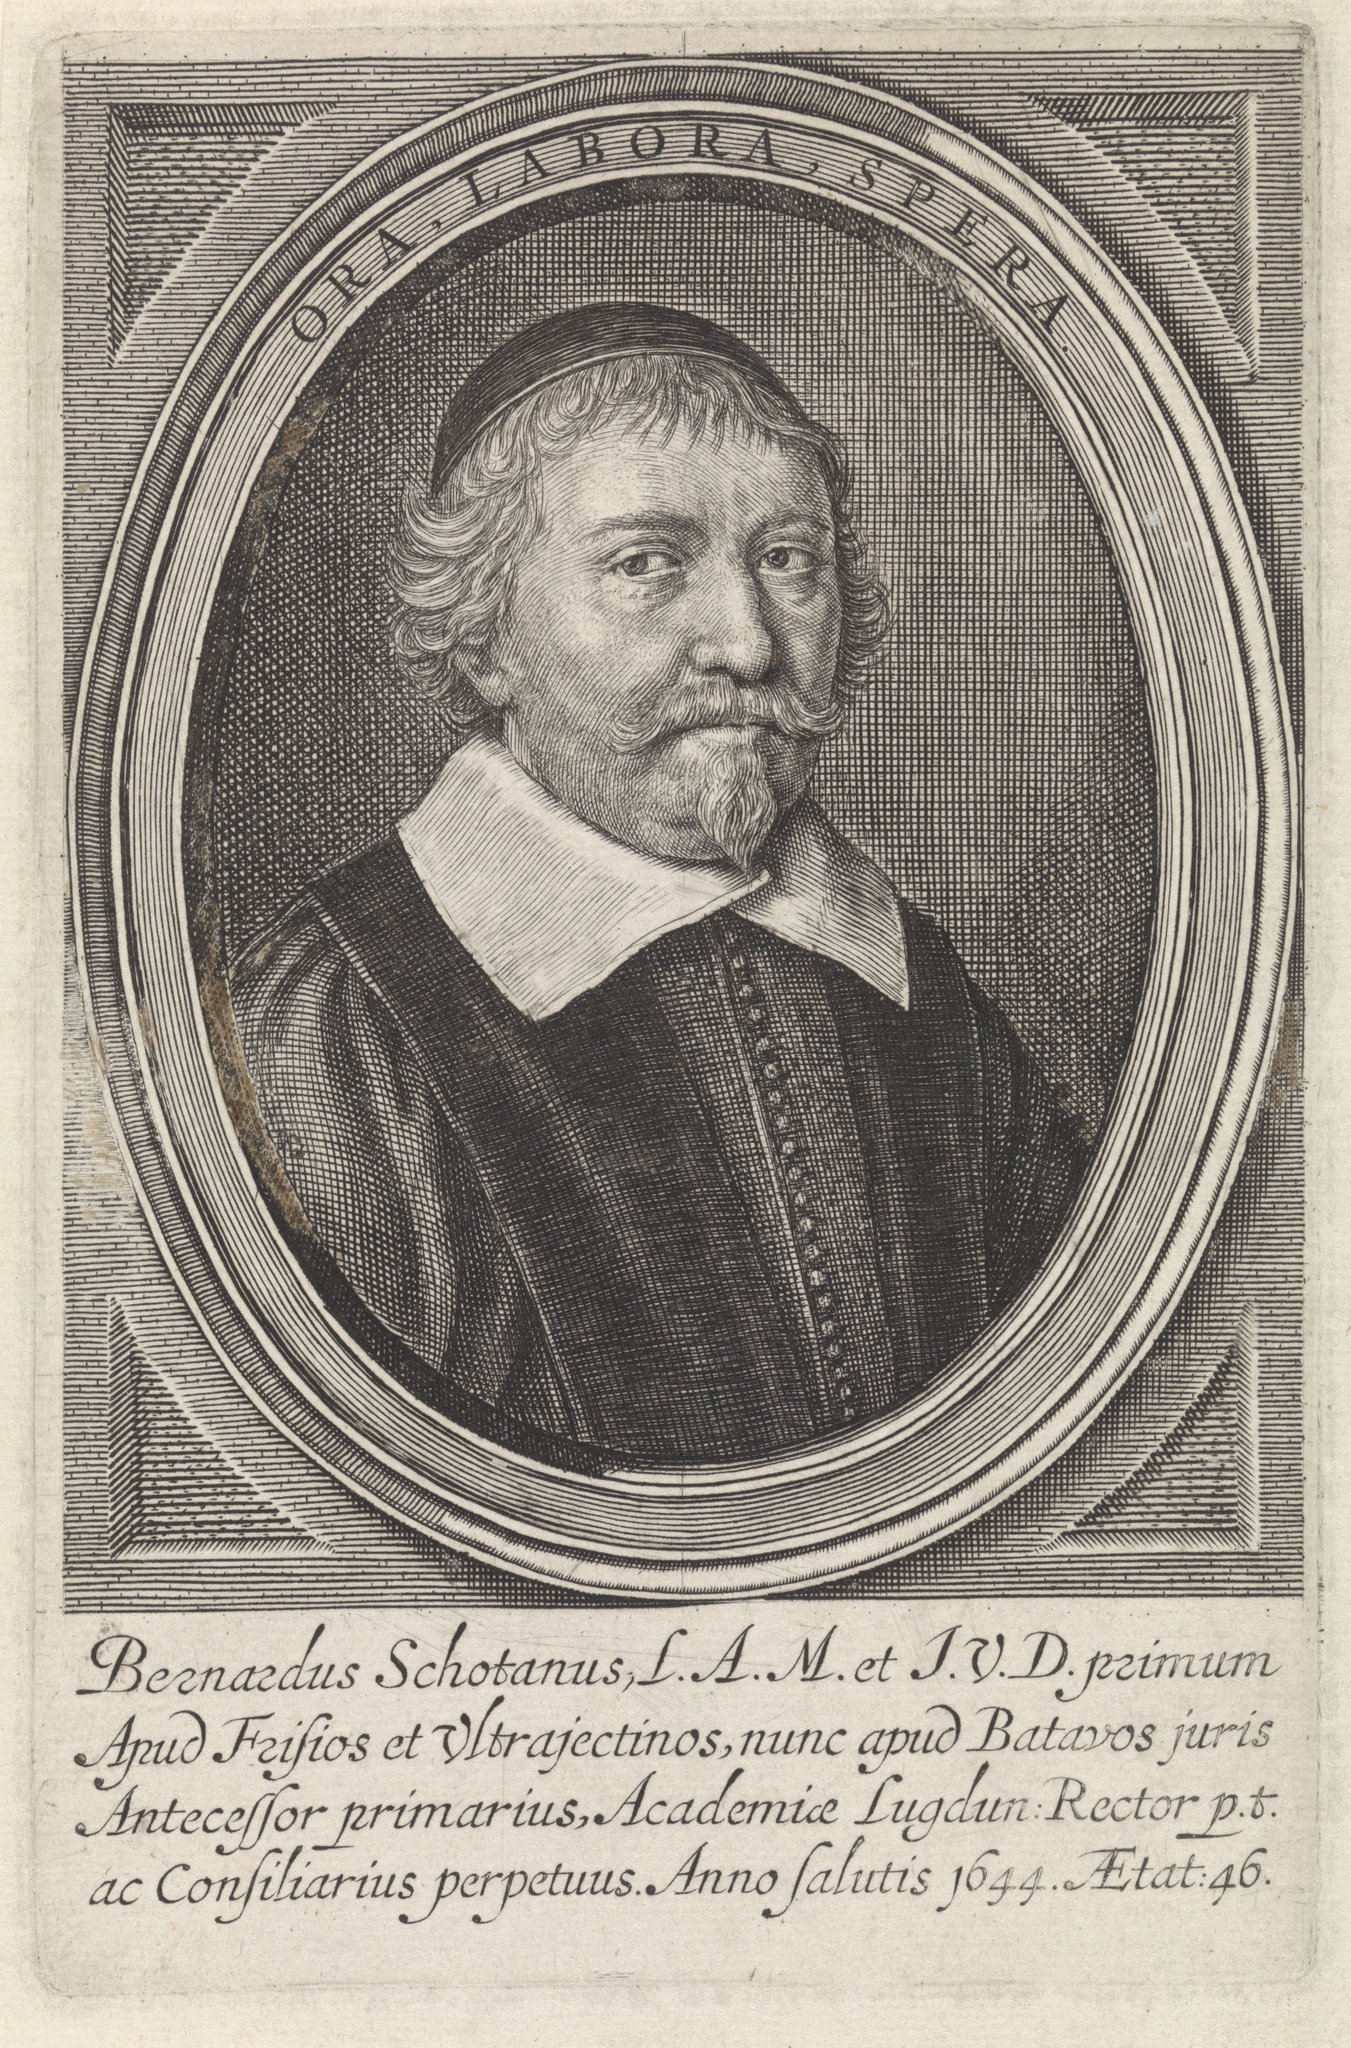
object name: print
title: Portret van Bernardus Schotanus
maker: crispijn van de passe (ii)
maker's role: draughtsman, print maker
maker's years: 1594-1670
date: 1644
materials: paper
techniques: engraving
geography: amsterdam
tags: bernardus schotanus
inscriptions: collector's mark: Lugt 240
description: Portret van de hoogleraar Bernardus Schotanus, op 46-jarige leeftijd. In het randschrift van de omlijsting zijn devies in het Latijn. In de marge een vierregelig onderschrift in het Latijn.